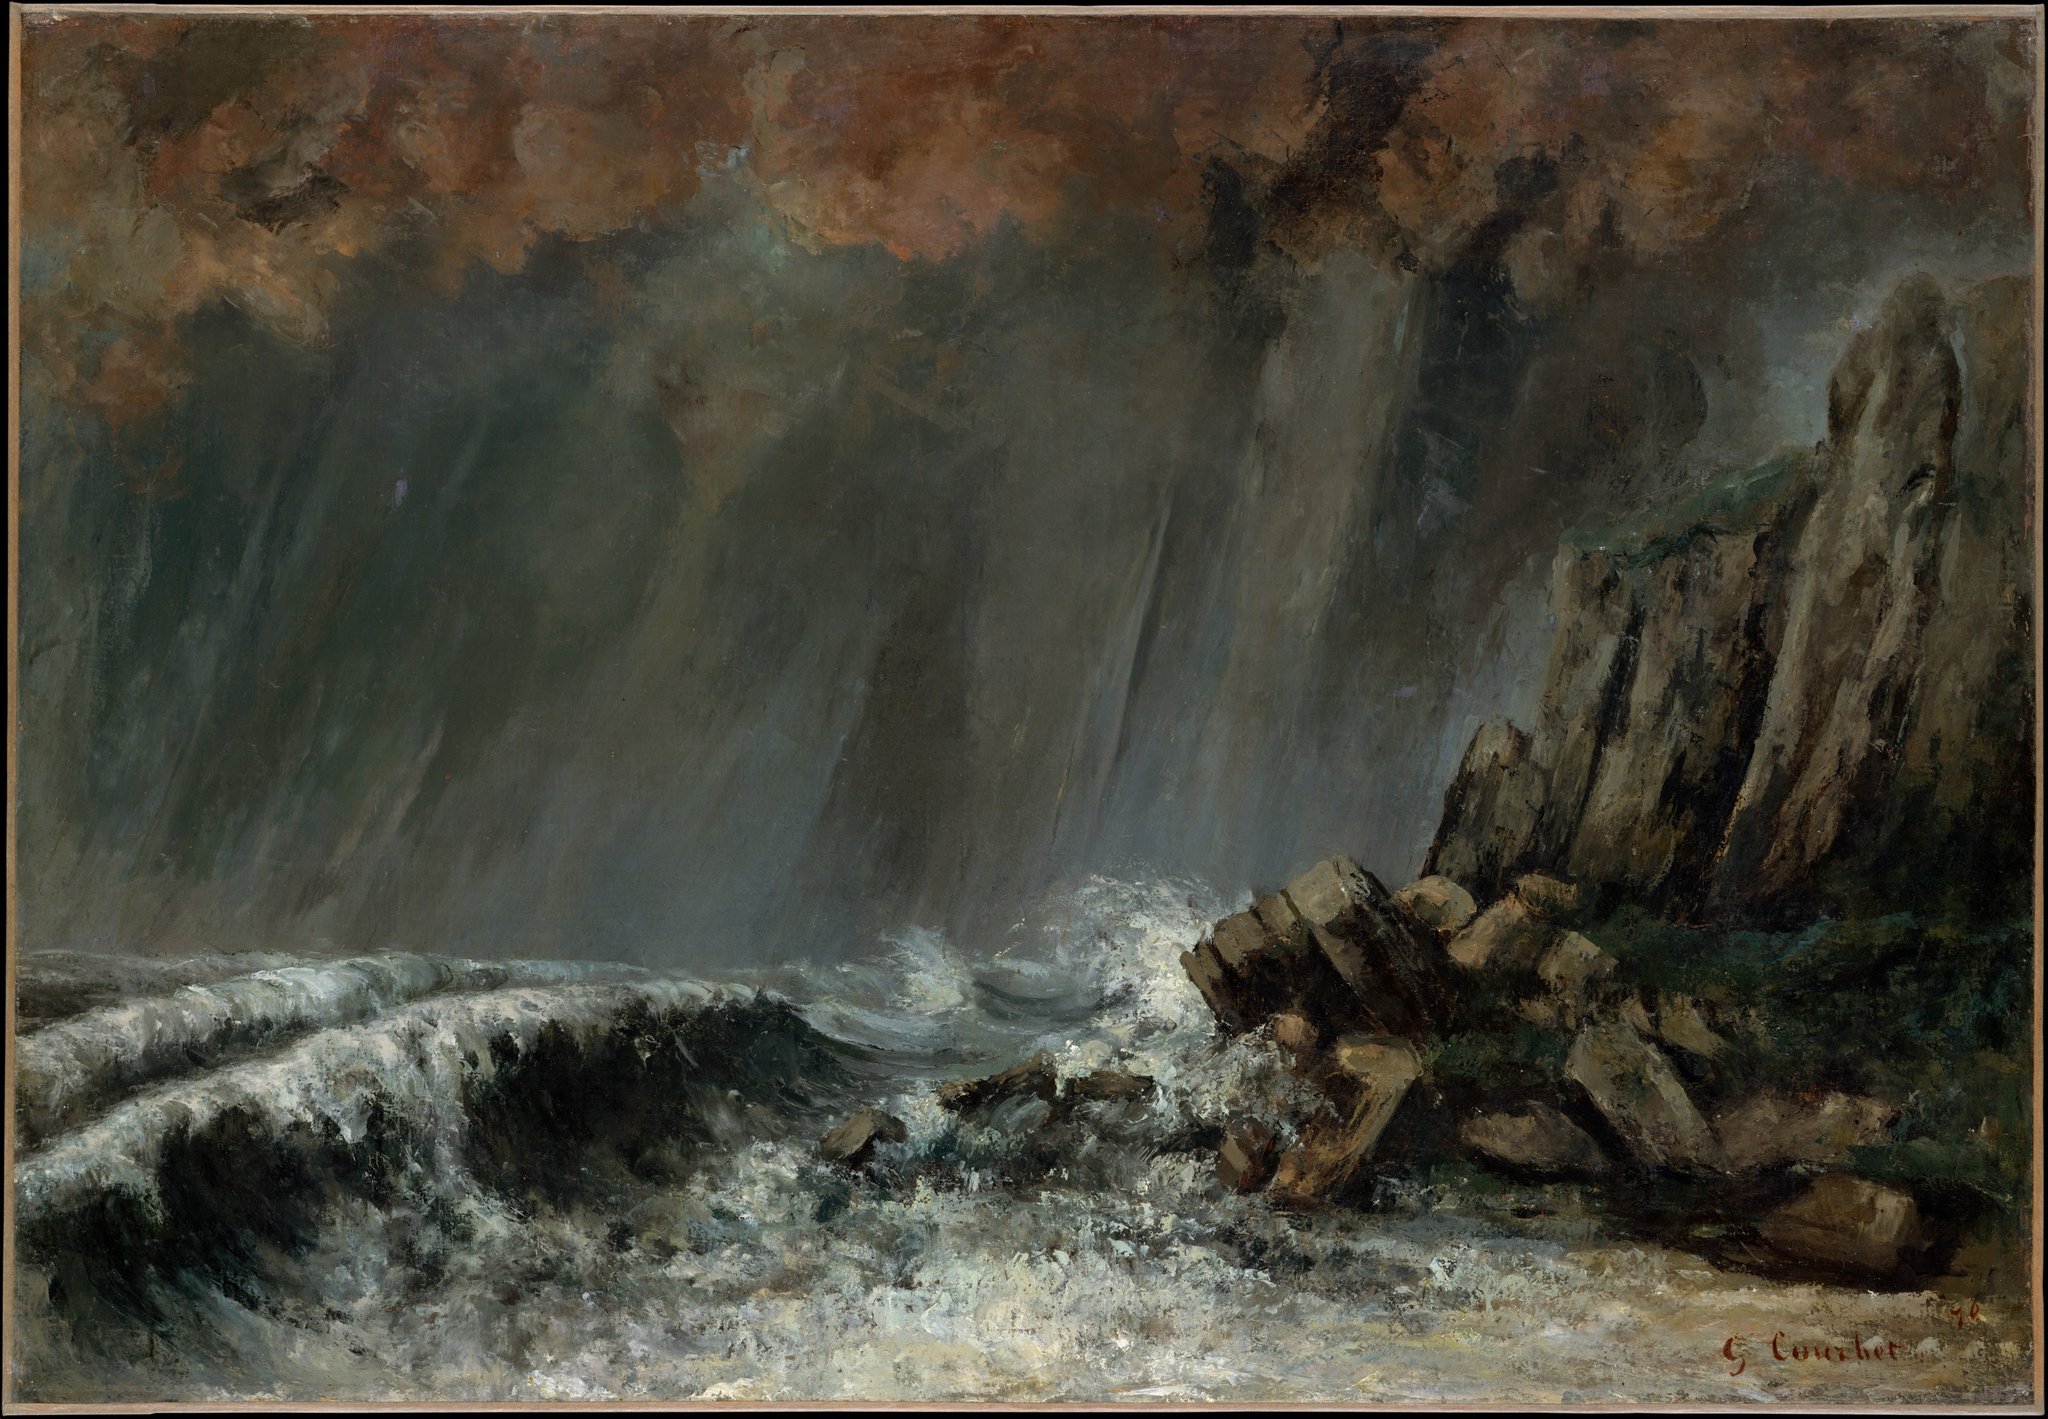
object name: painting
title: Marine: The Waterspout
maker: gustave courbet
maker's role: artist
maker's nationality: french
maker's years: 1819-1877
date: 1870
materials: canvas, oil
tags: seascapes,waves